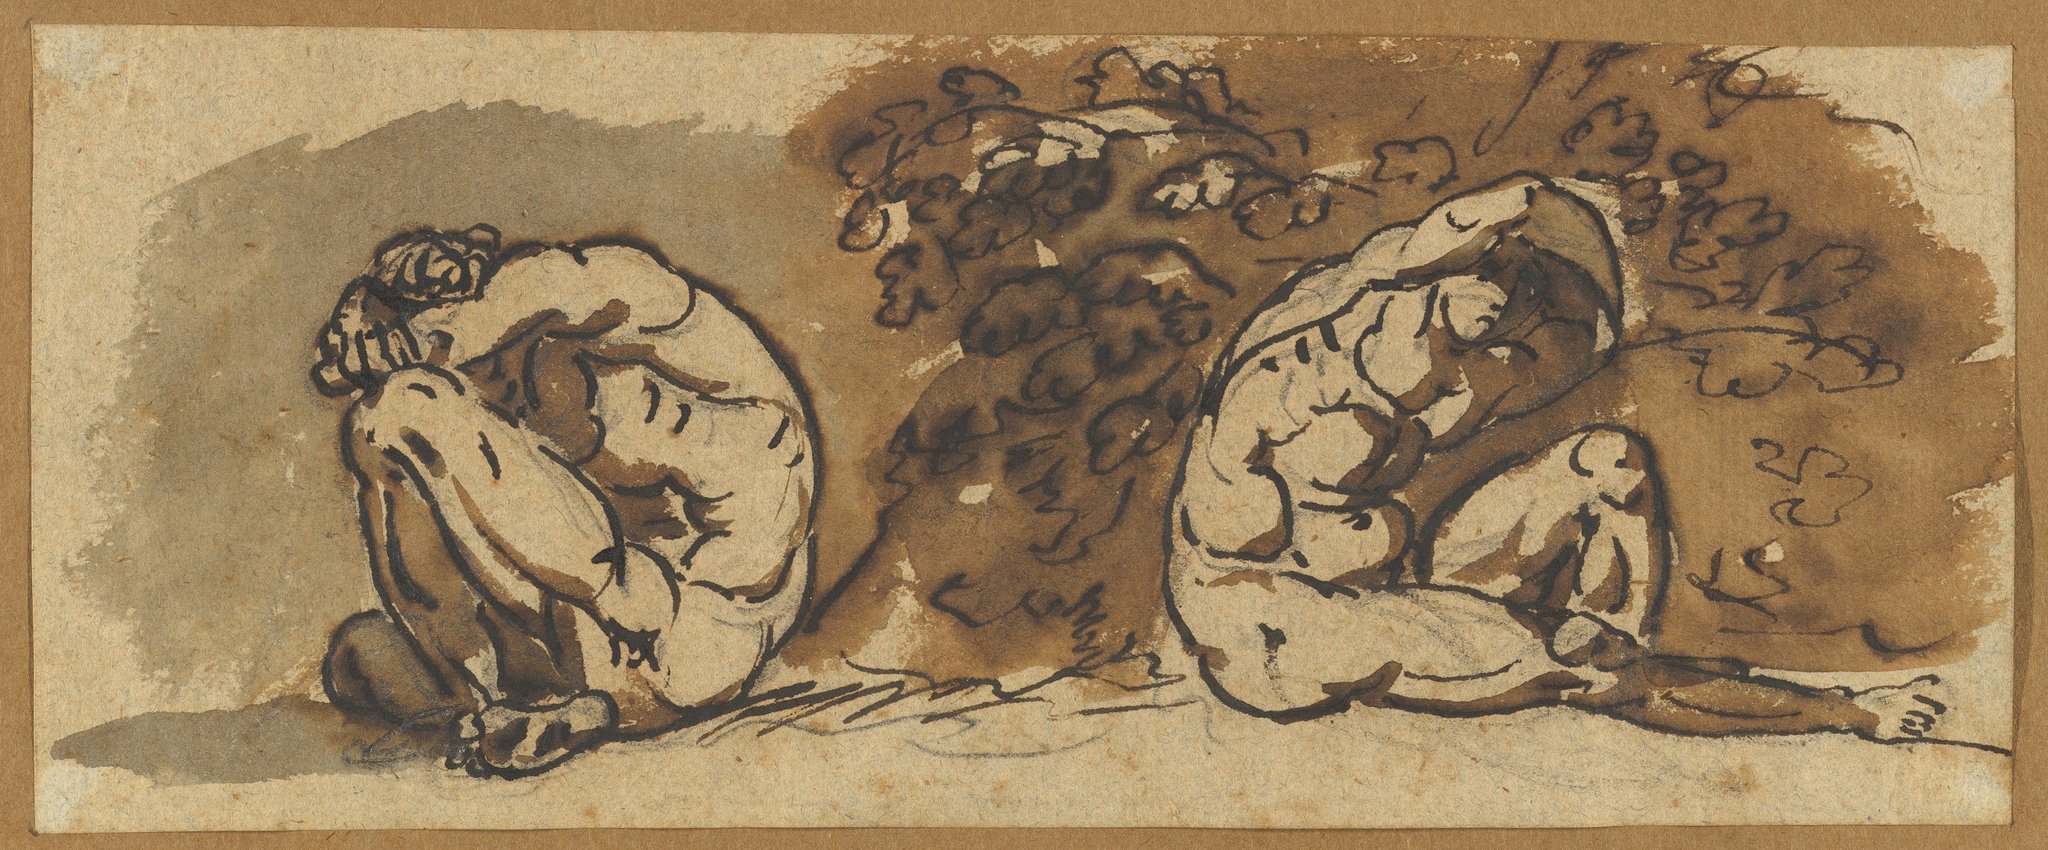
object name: drawing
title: Two Studies of a Male Nude (Althaemenes) Hiding in a Bush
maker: nicolai abraham abildgaard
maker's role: artist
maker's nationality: danish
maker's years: 1743-1809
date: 1734-1833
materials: graphite, ink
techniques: pen, wash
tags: male nudes,plants